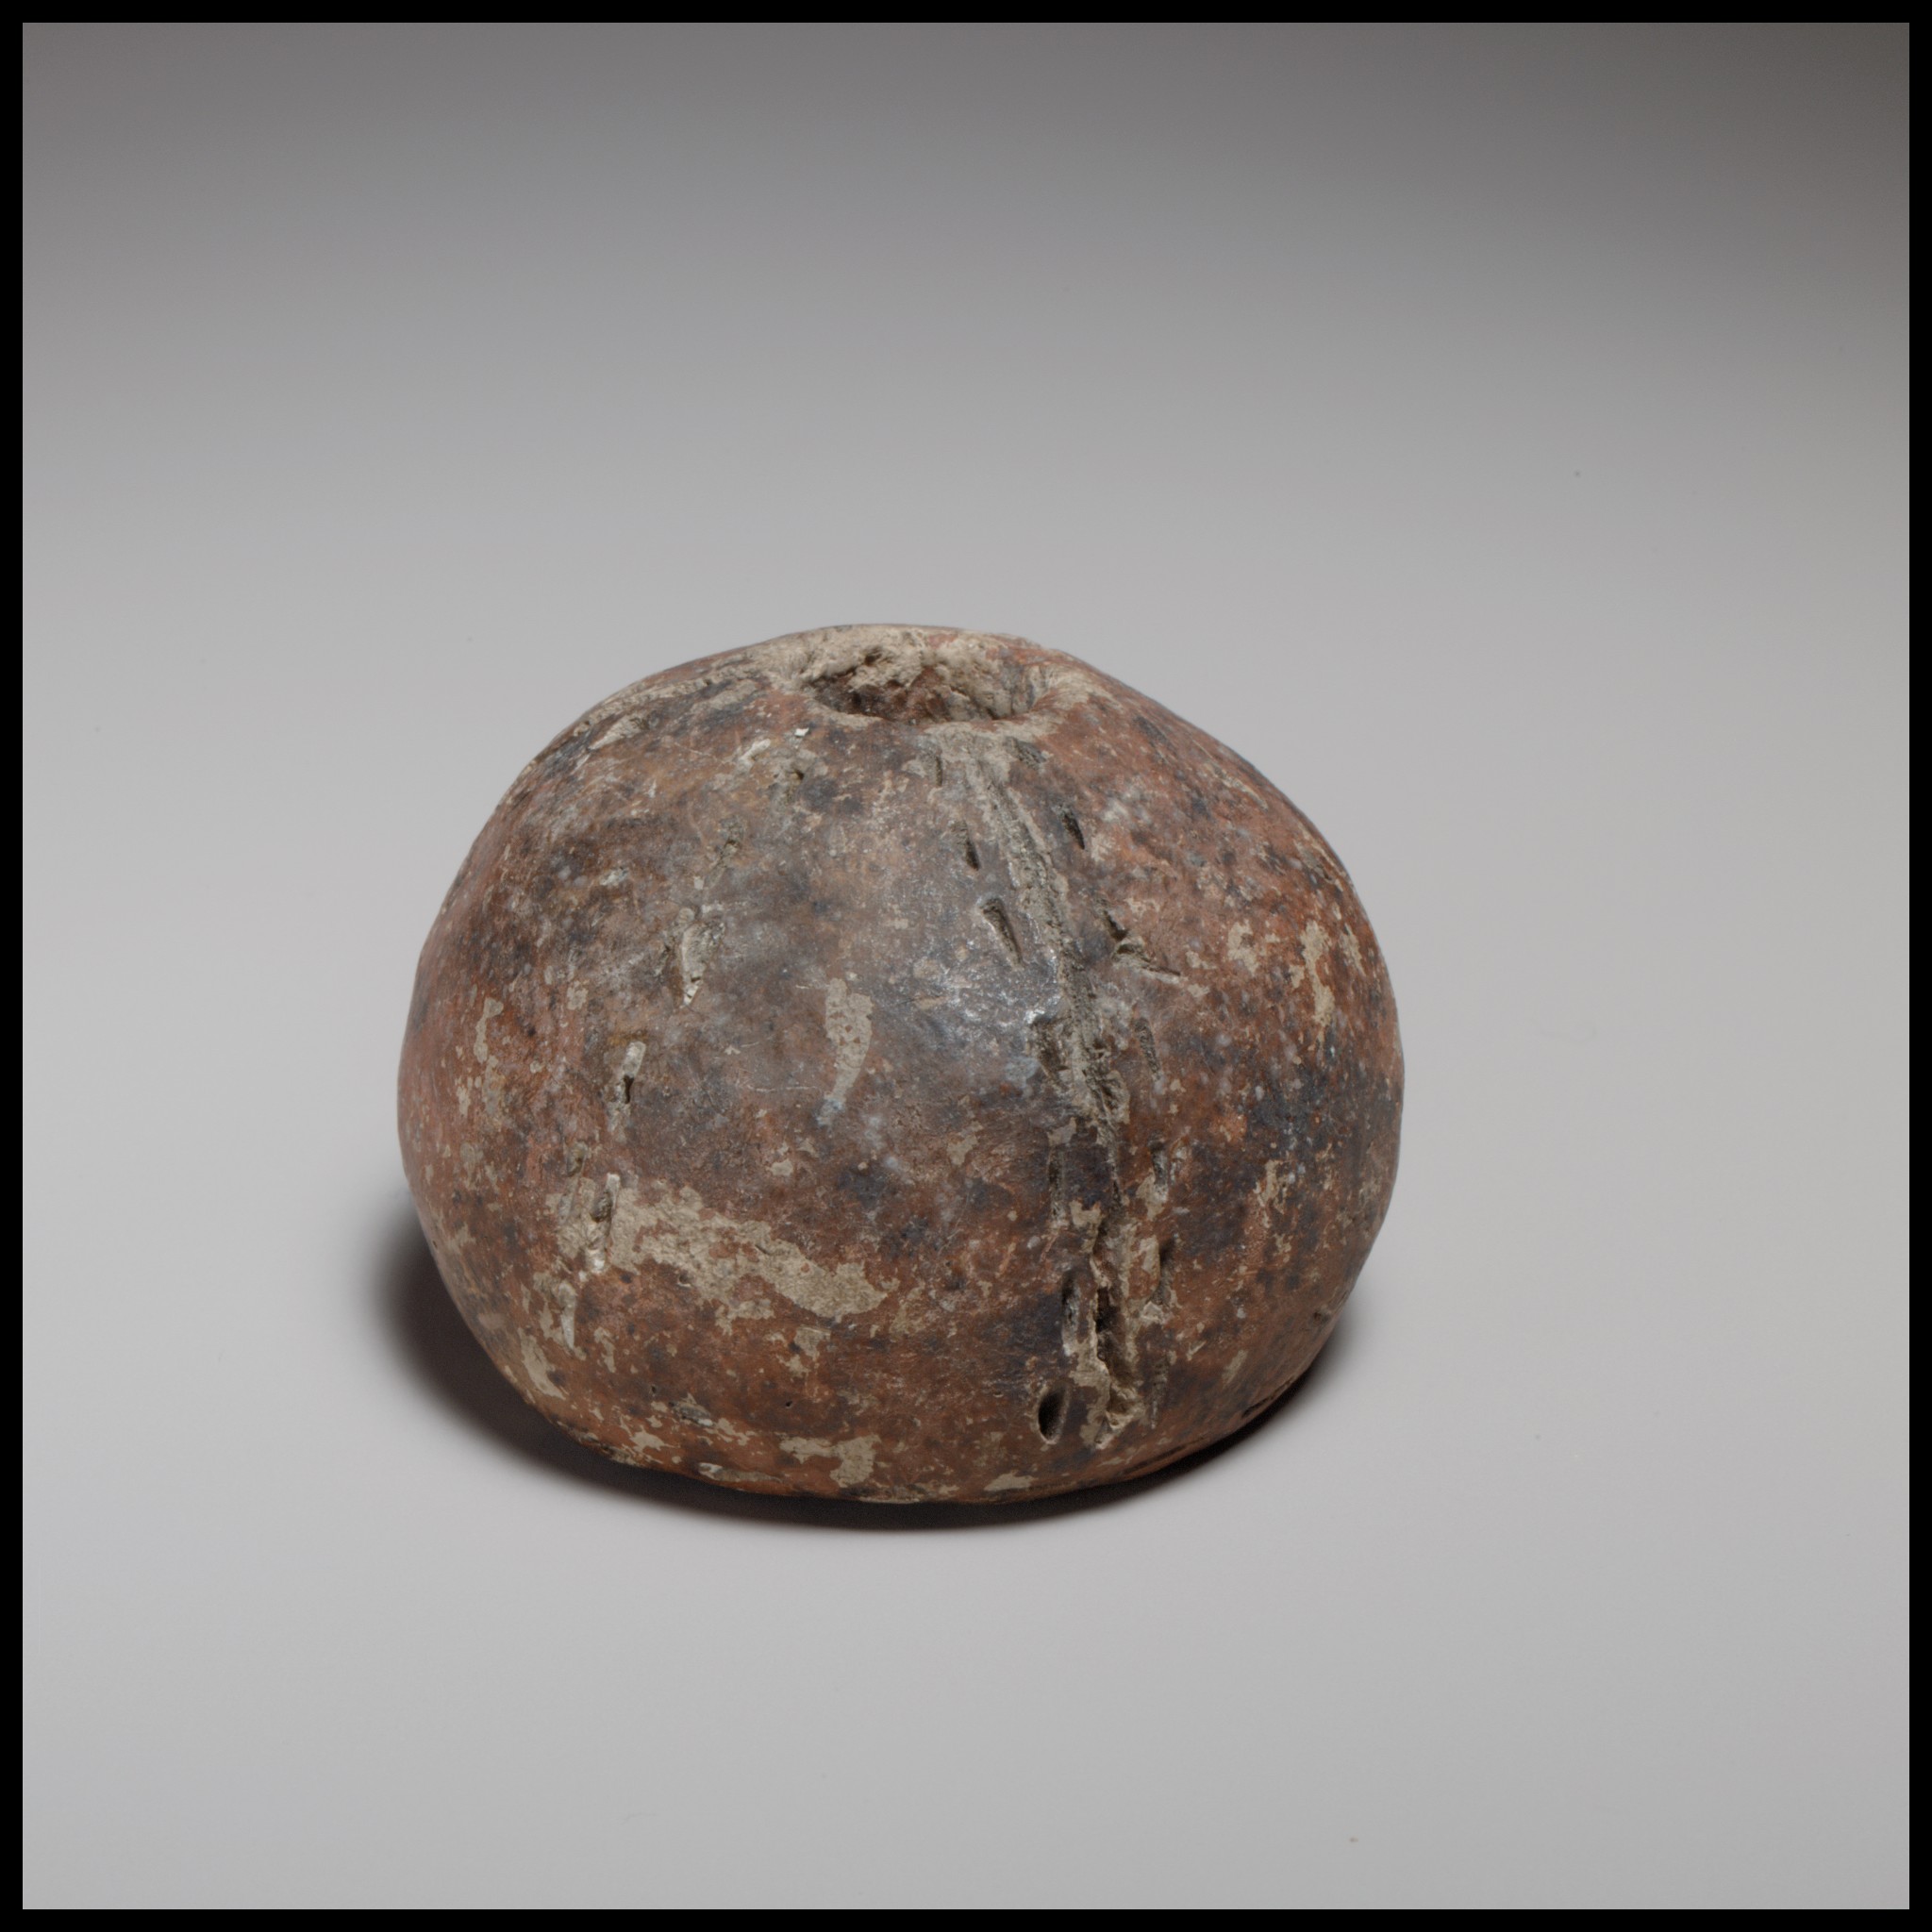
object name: spindle whorl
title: Spherical spindle-whorl with flat base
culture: cypriot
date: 2000-1725 BCE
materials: terracotta